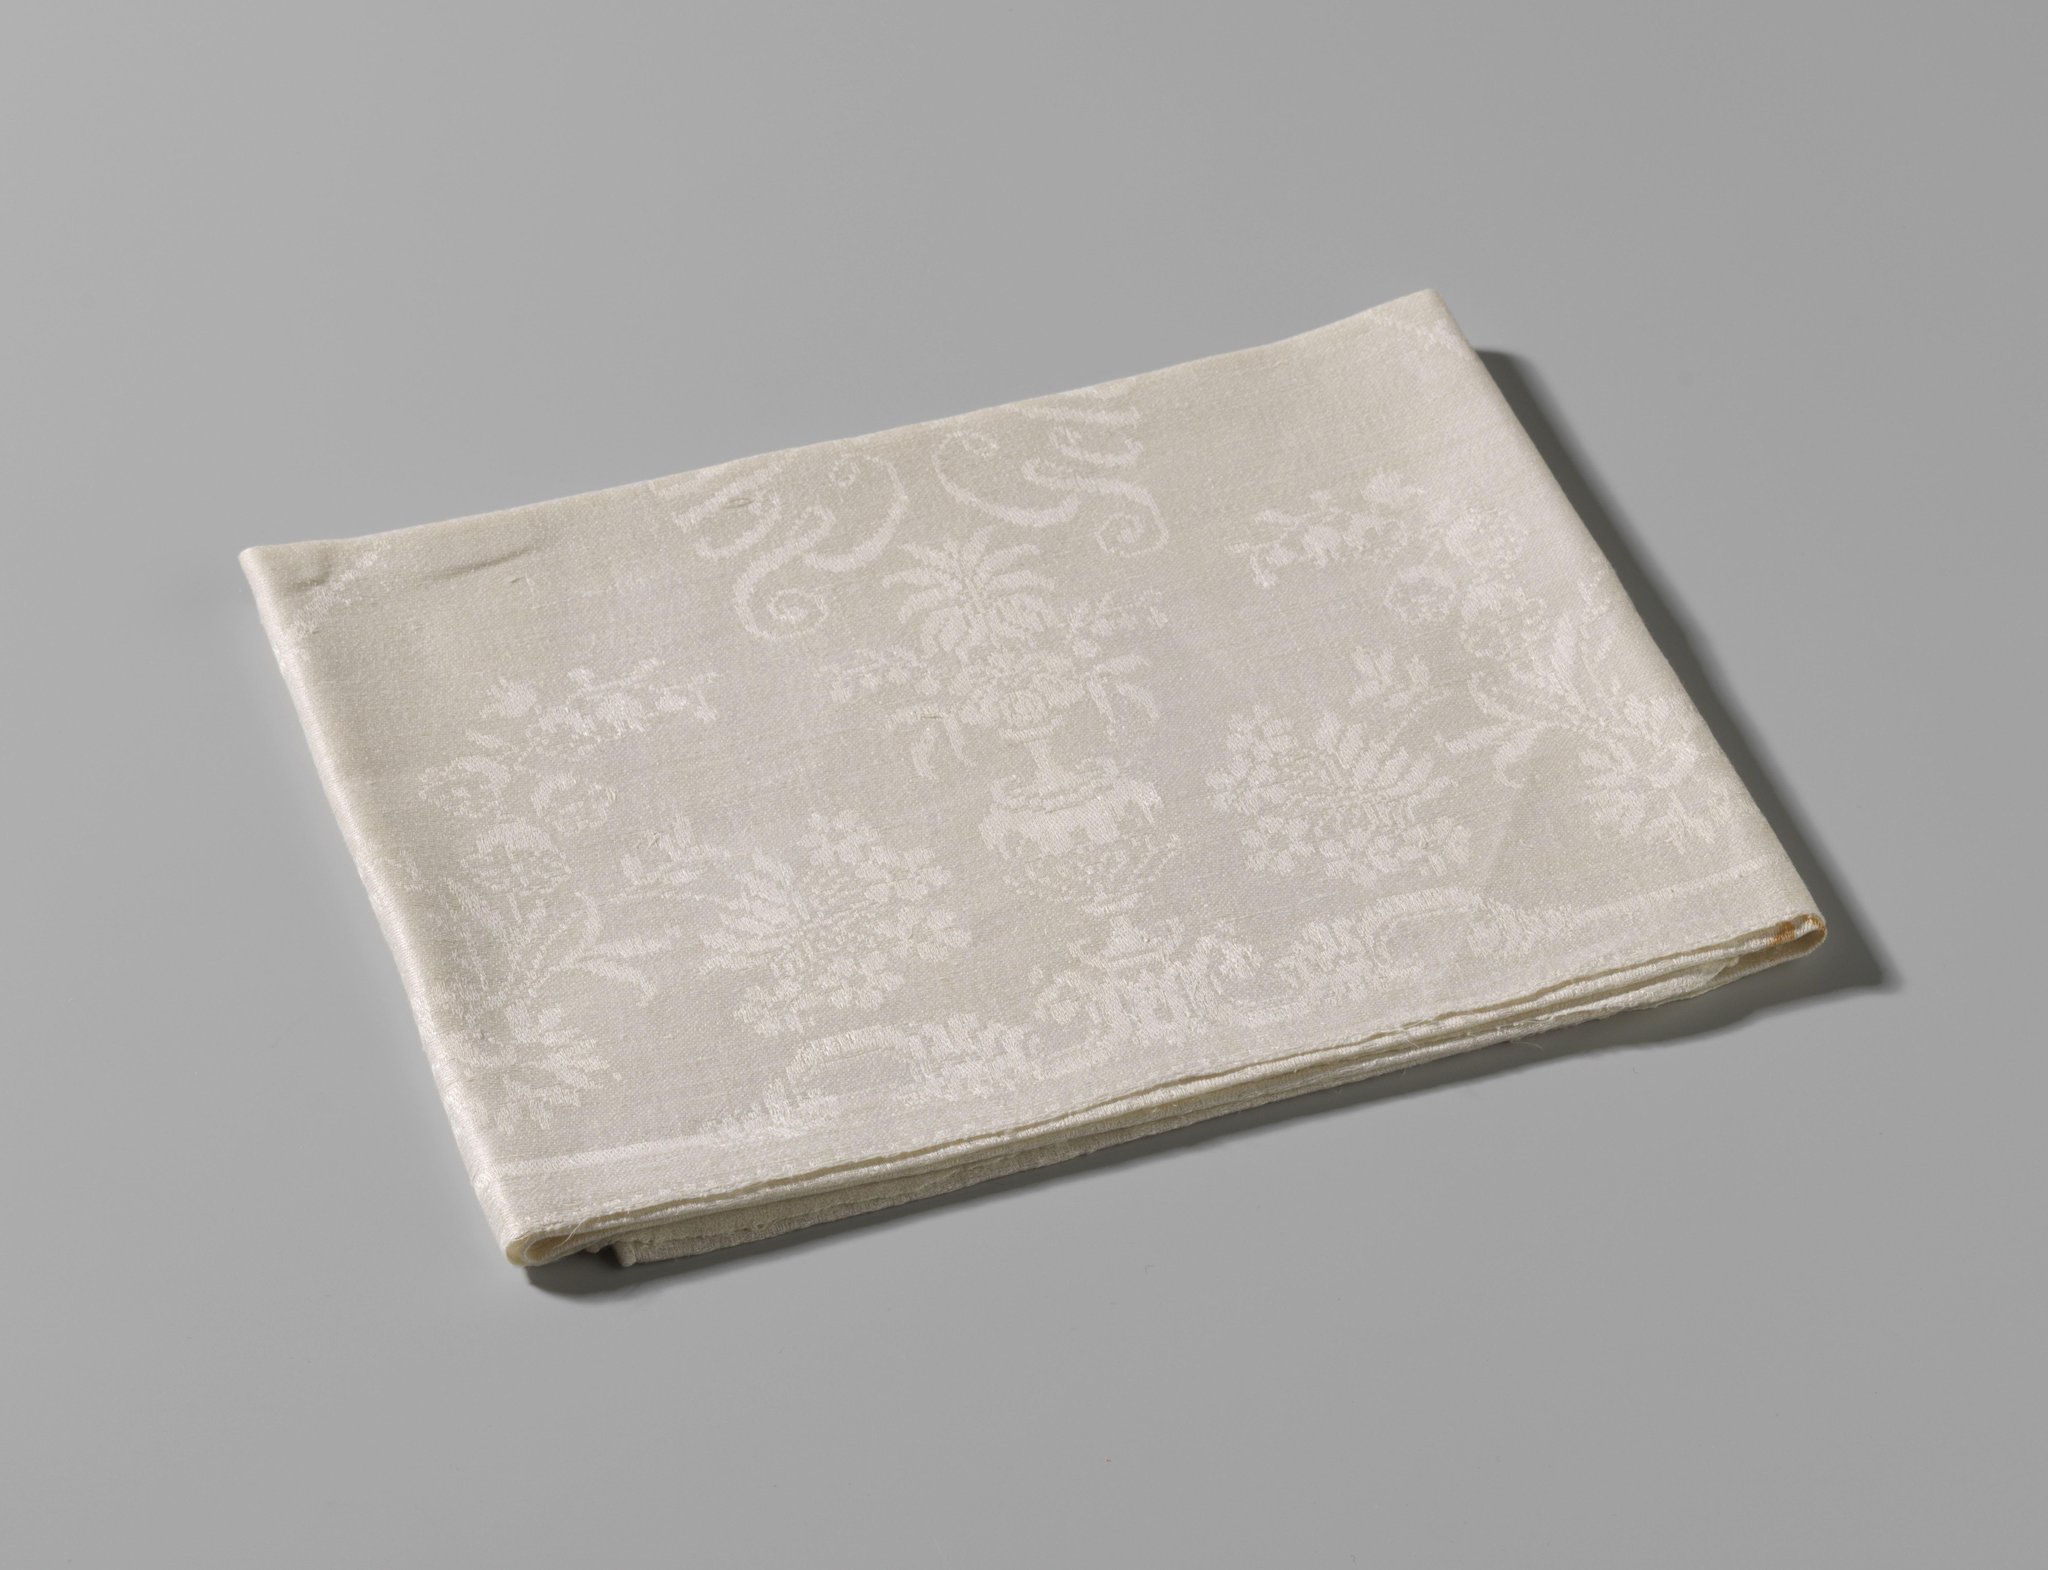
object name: cloth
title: Doek met ruiten, sterren en in de hoeken Maria met kind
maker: Anonymous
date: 1700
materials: linen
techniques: damask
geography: germany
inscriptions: mark: ‘EL’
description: Doek van linnendamast met ruiten, sterren en in de hoeken Maria met kind. Middenveld: vierkant met ruiten en vier sterren. De rand wordt gevormd door een symmetrisch aangebrachte versiering van ranken en bloemen ter weerszijden van een vaas met bloemen als centraal motief. Hoeken: Maria met kind op de arm, beiden gekroond en met een aureool omgeven. Daarboven in een boog: Gelobt seij Jesus Christus; eronder in een boog in tegenovergestelde richting: In Ewigkeit Amen.